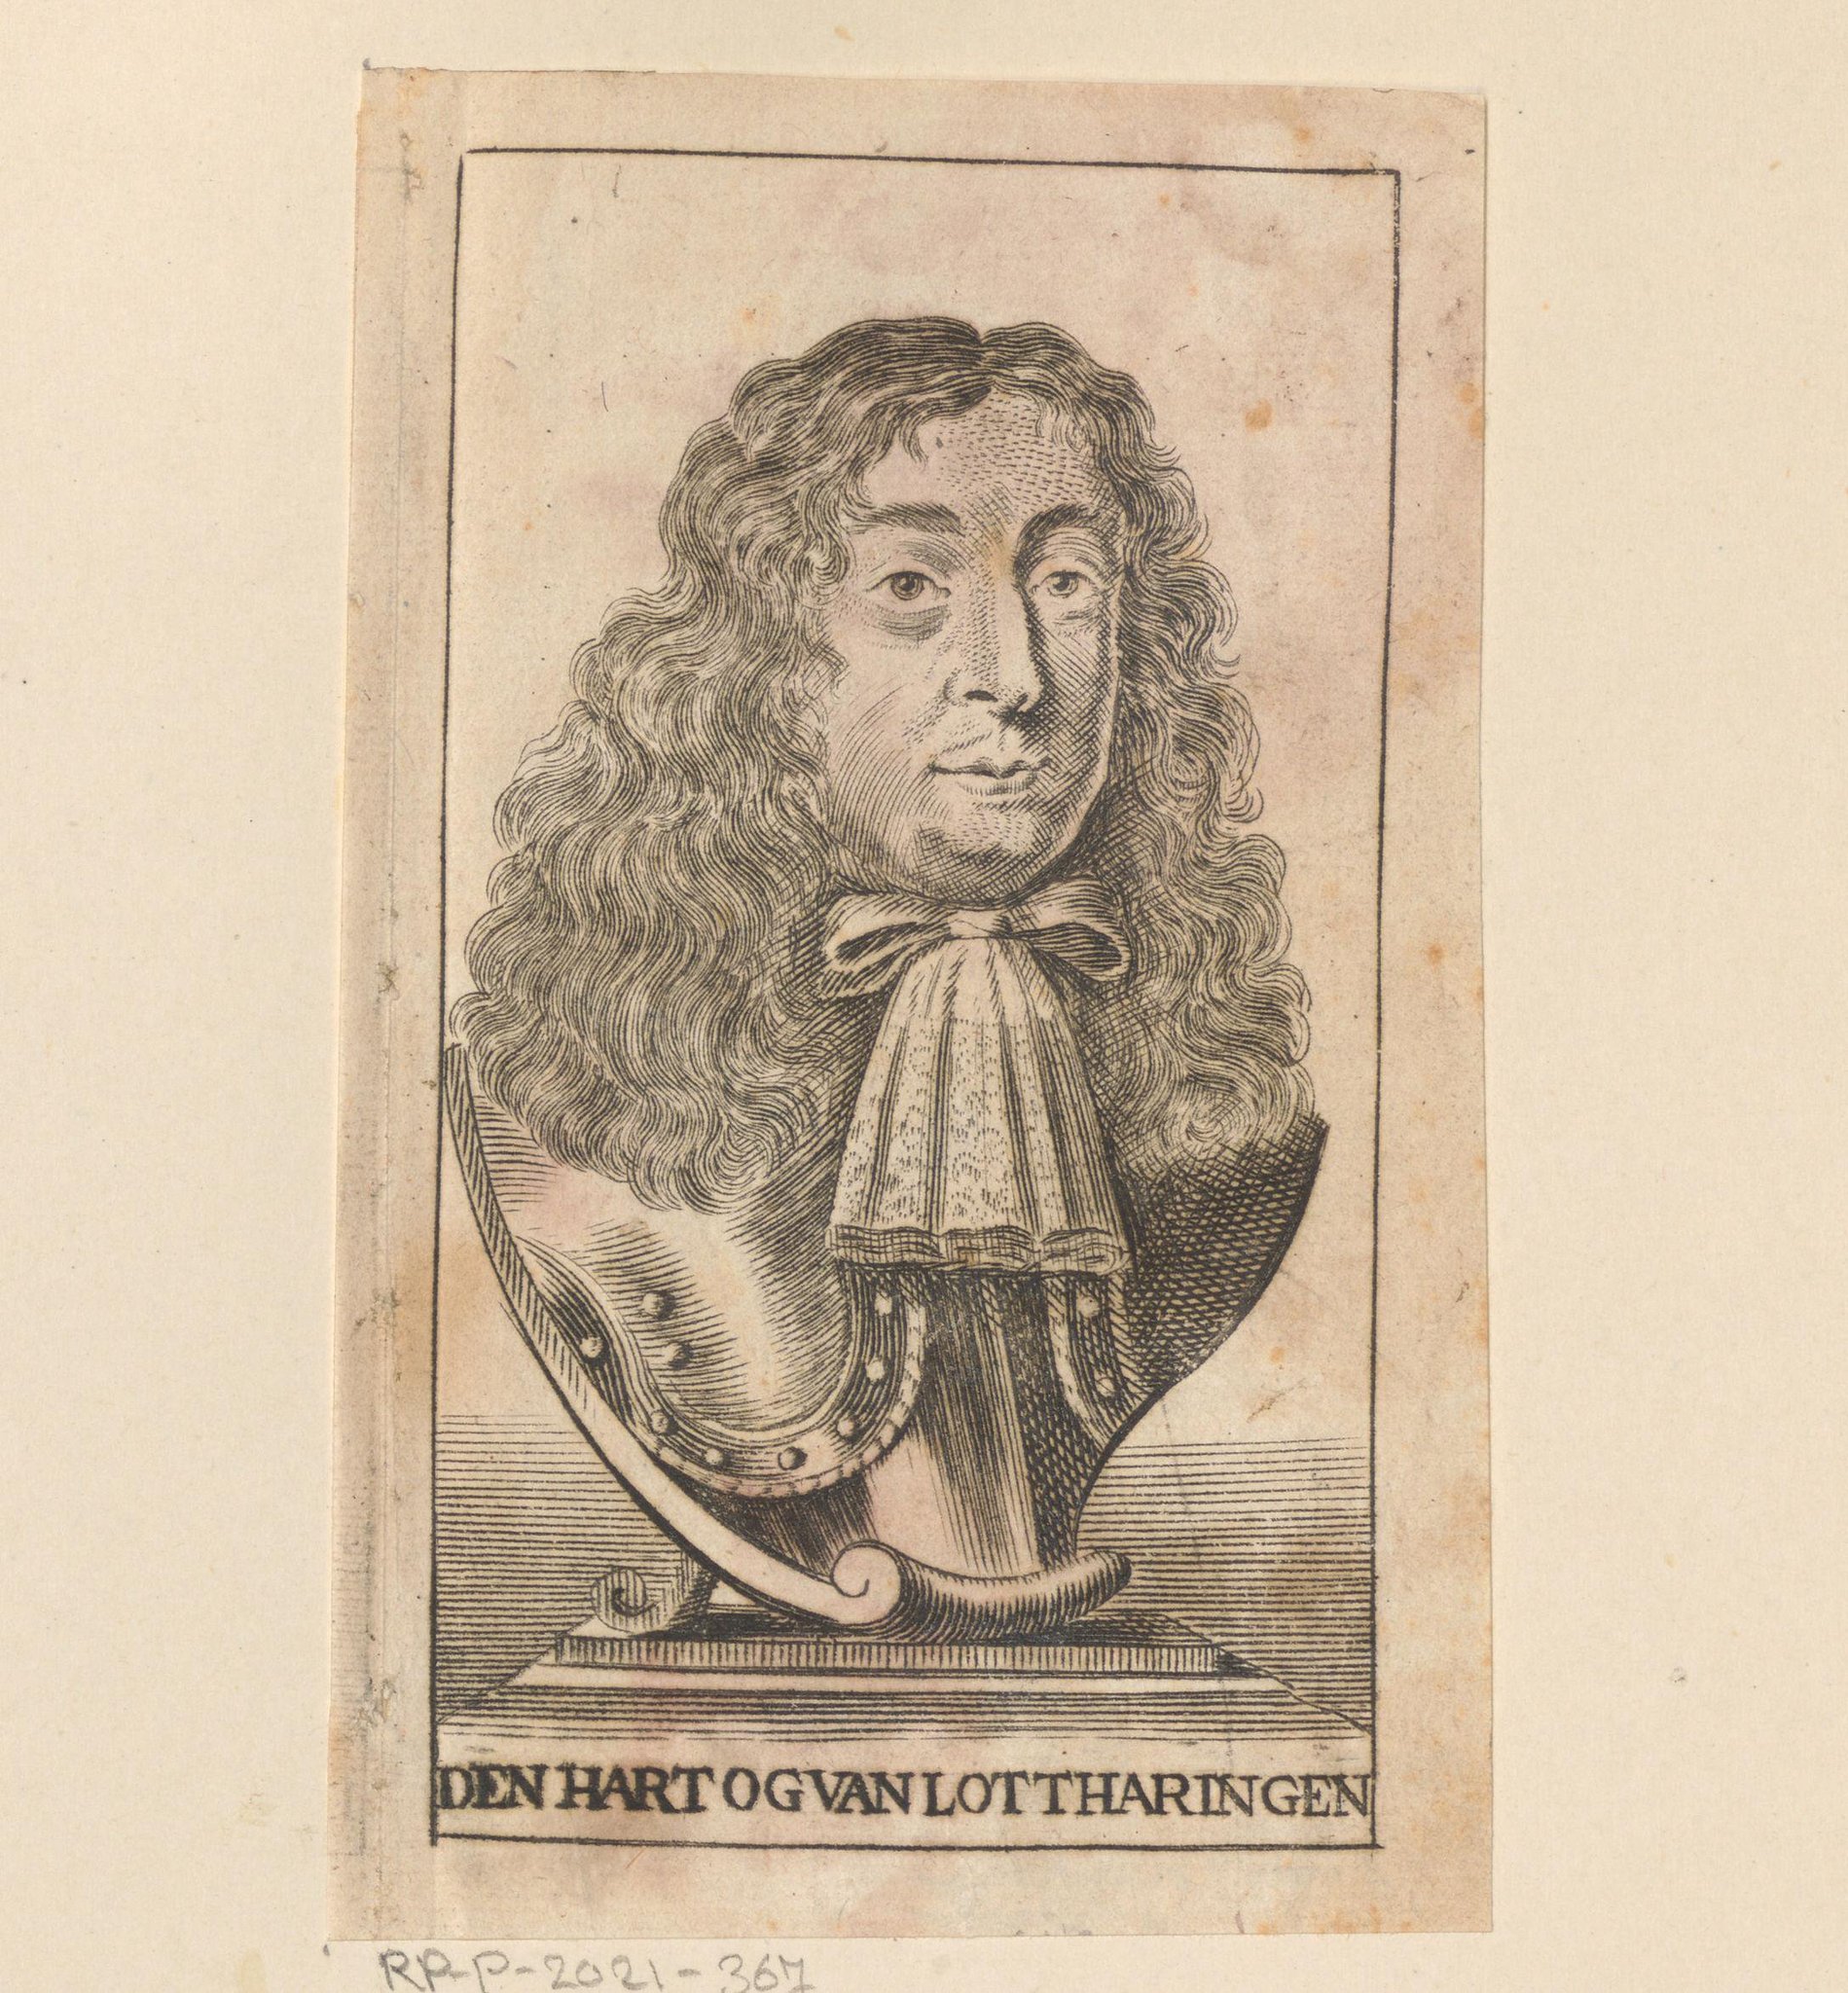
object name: print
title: Portret van Karel V Leopold, hertog van Lotharingen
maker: Anonymous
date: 1675-1749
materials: paper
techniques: engraving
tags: vienna, other sovereign, historical persons